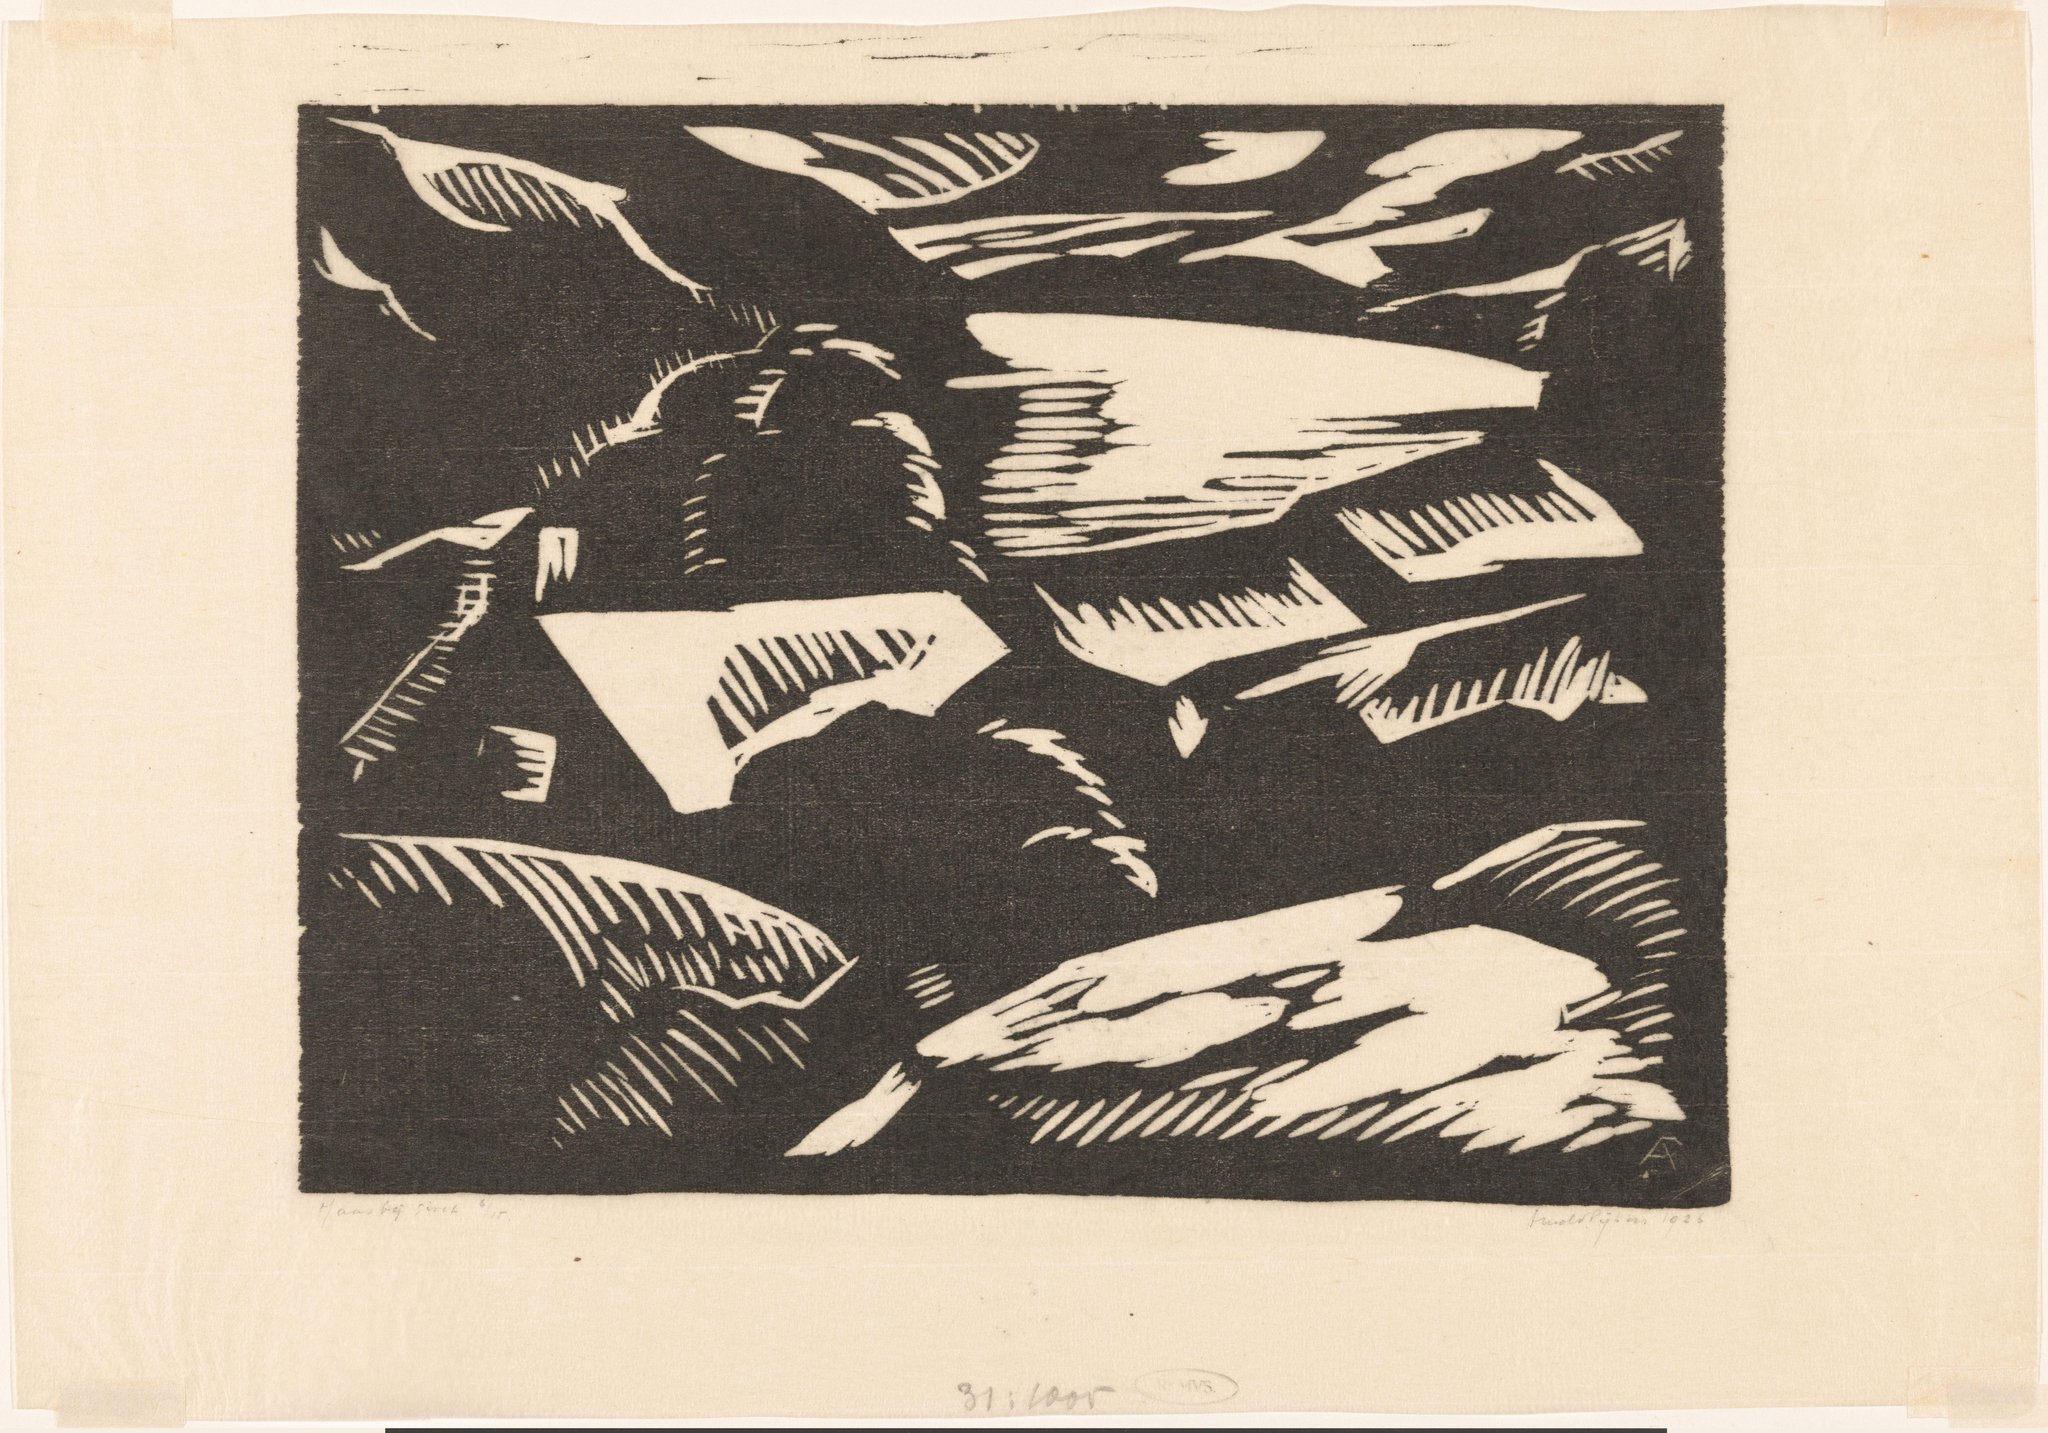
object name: print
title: Maas bij Givet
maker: arnold pijpers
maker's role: print maker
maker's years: 1900-1951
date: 1926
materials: paper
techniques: woodcut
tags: river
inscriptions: collector's mark: Lugt 2228